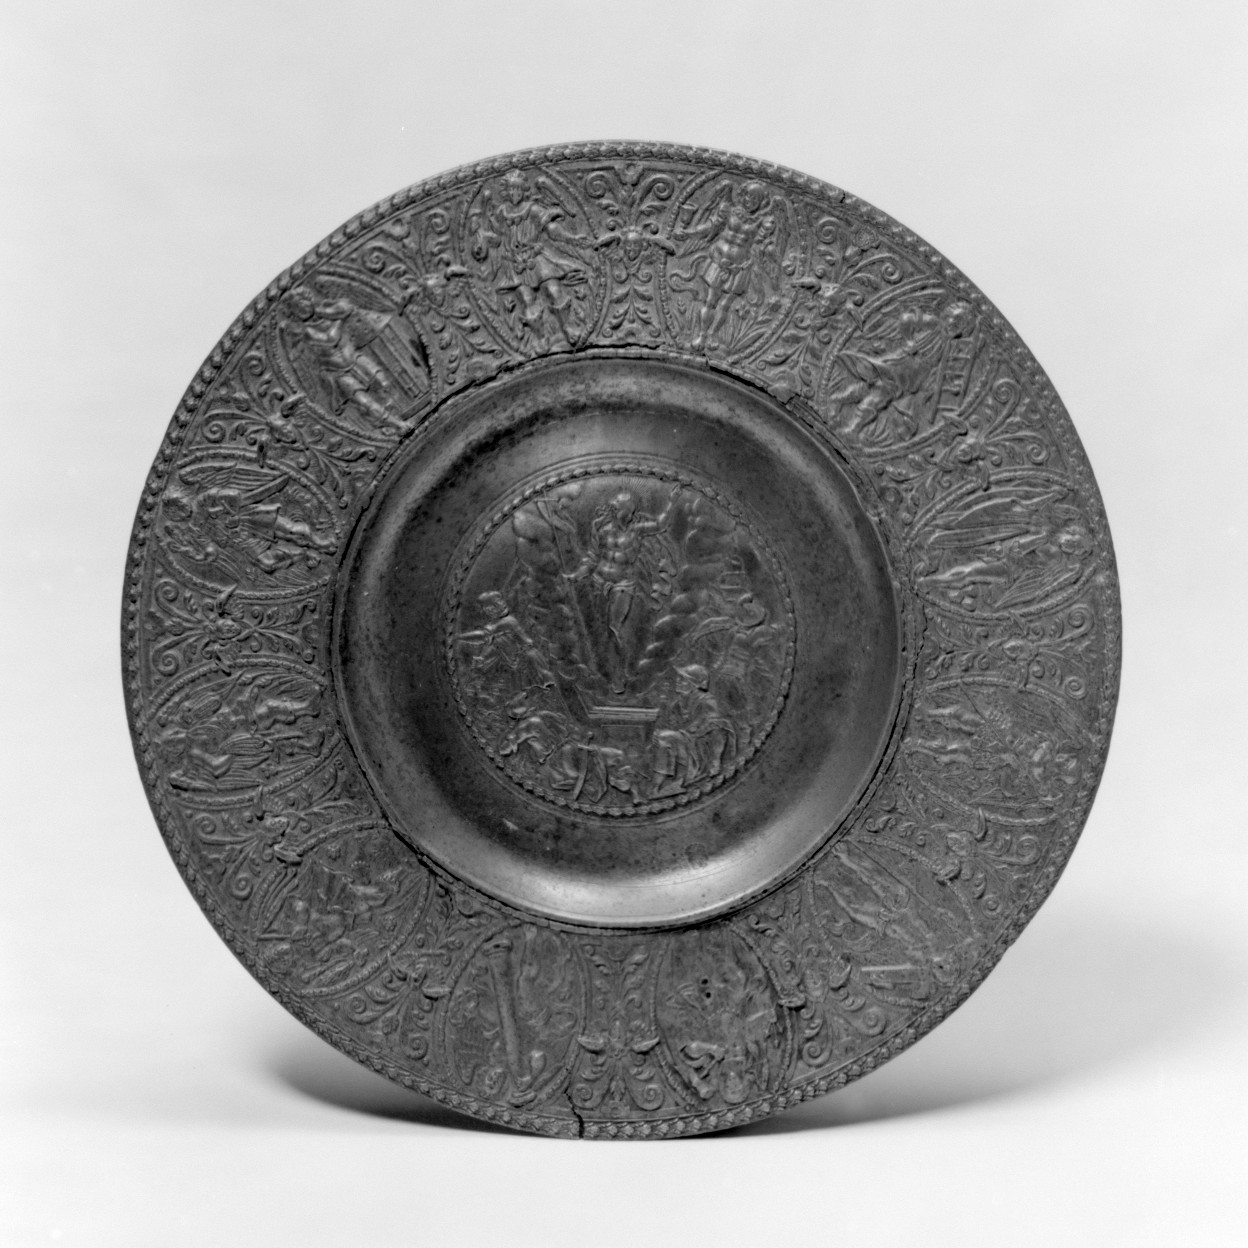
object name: plate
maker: hans spatz ii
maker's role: maker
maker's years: 1570-1670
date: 1630-1660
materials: pewter